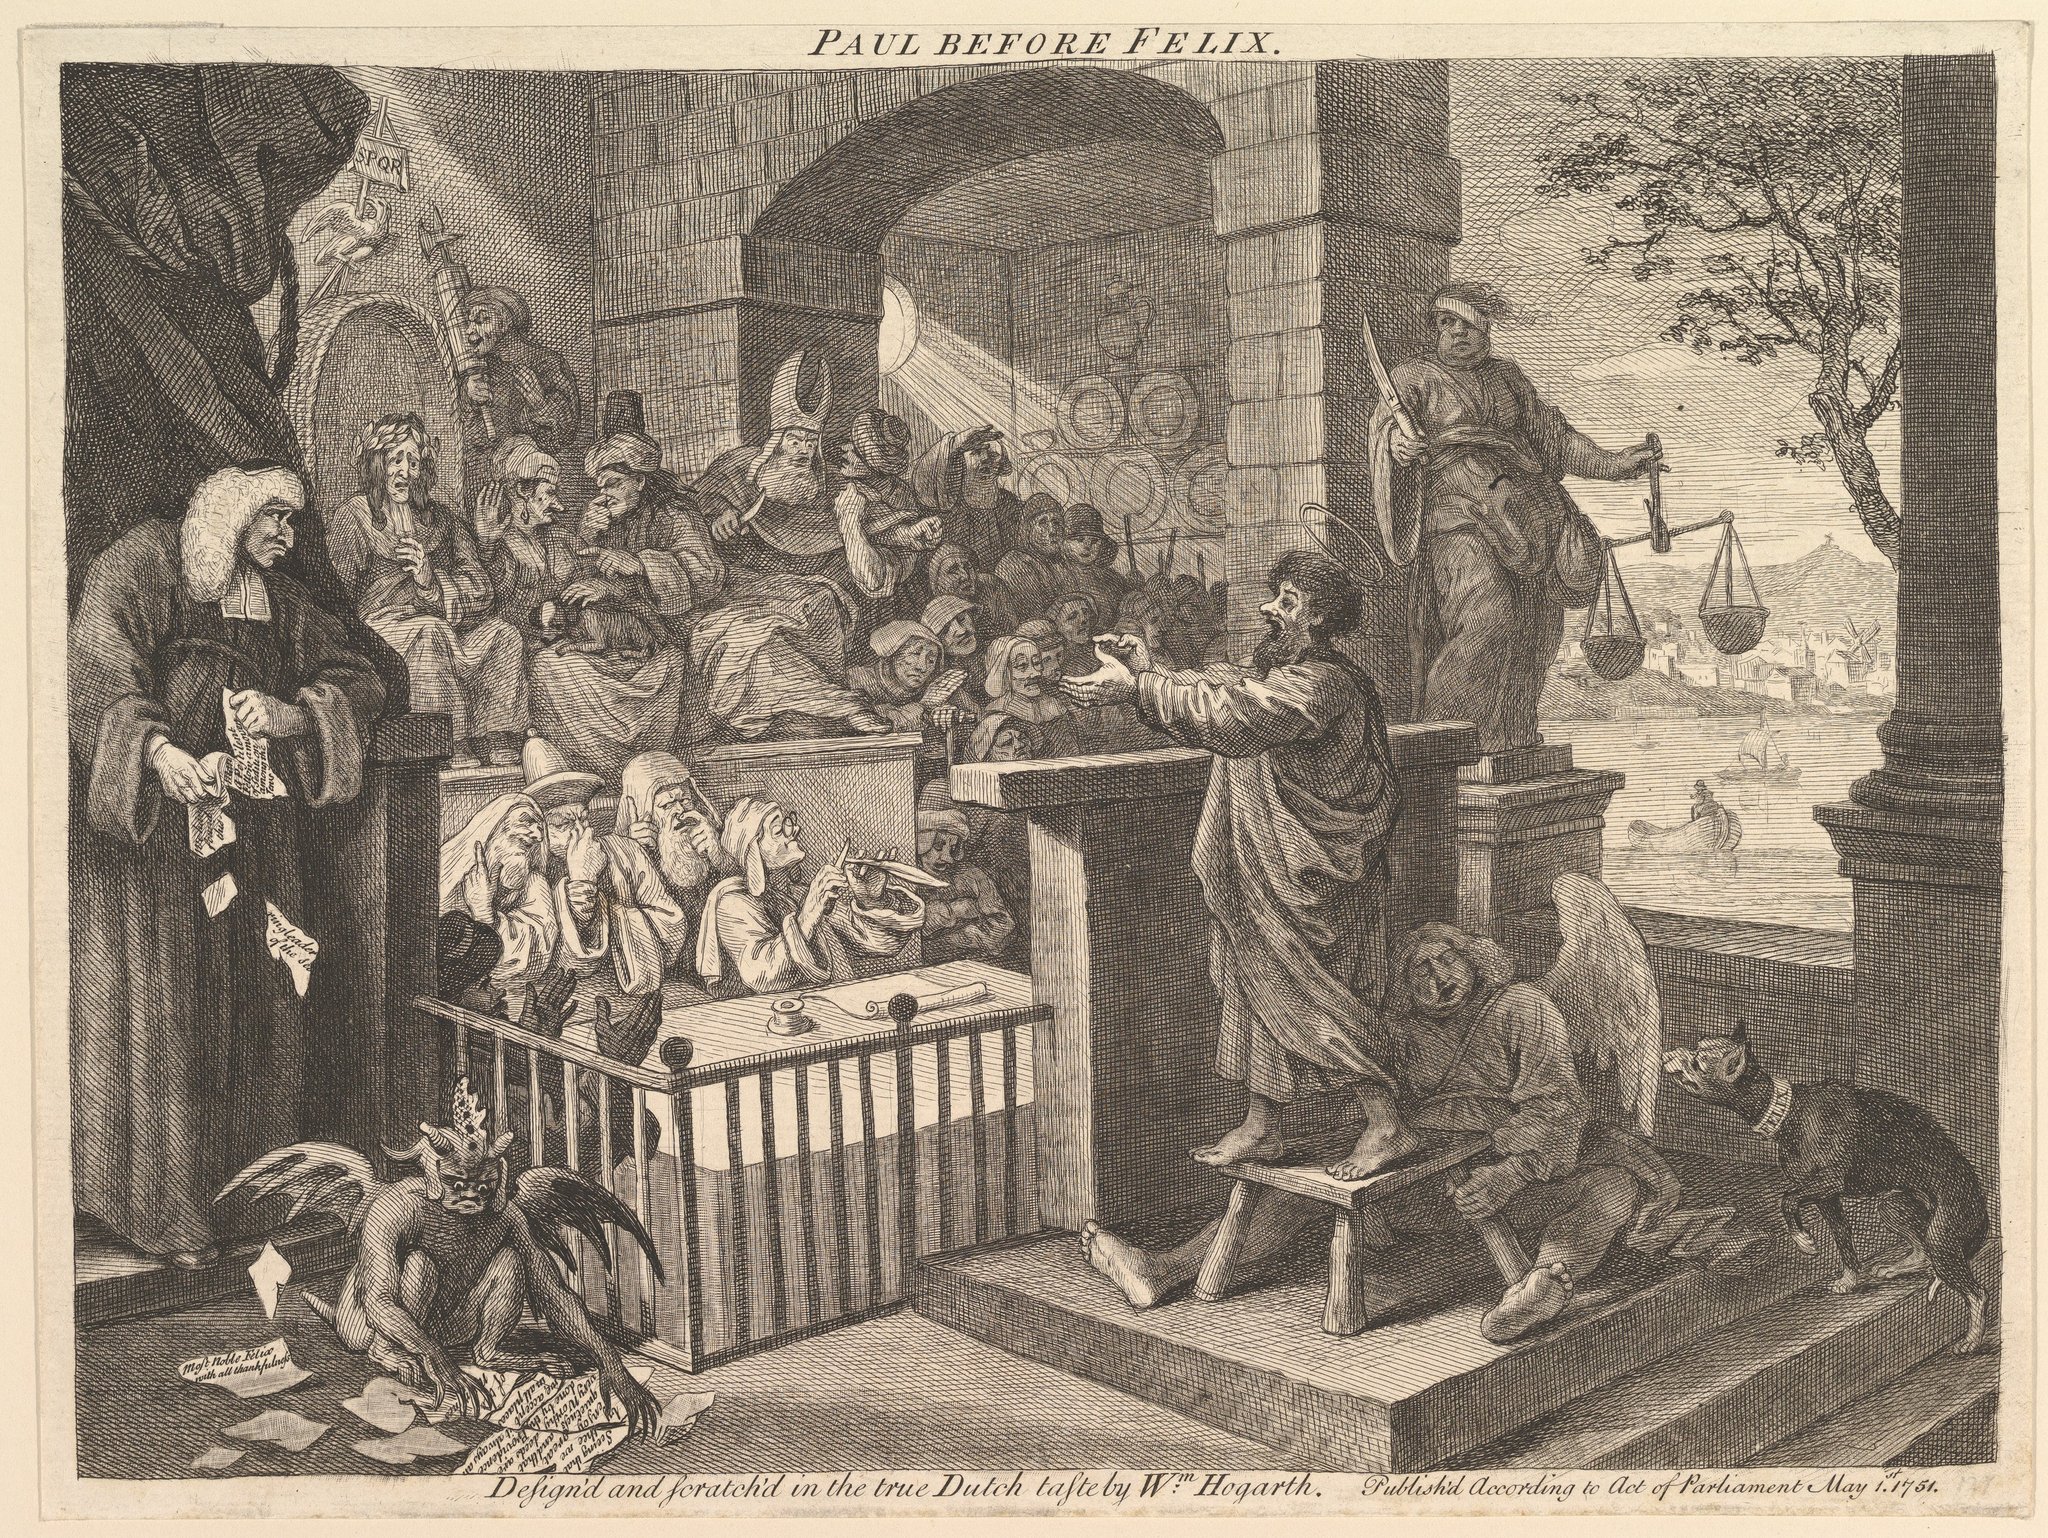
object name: print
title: Paul Before Felix Burlesqued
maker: william hogarth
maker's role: artist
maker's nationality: british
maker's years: 1697-1764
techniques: engraving, etching, mezzotint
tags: men,law